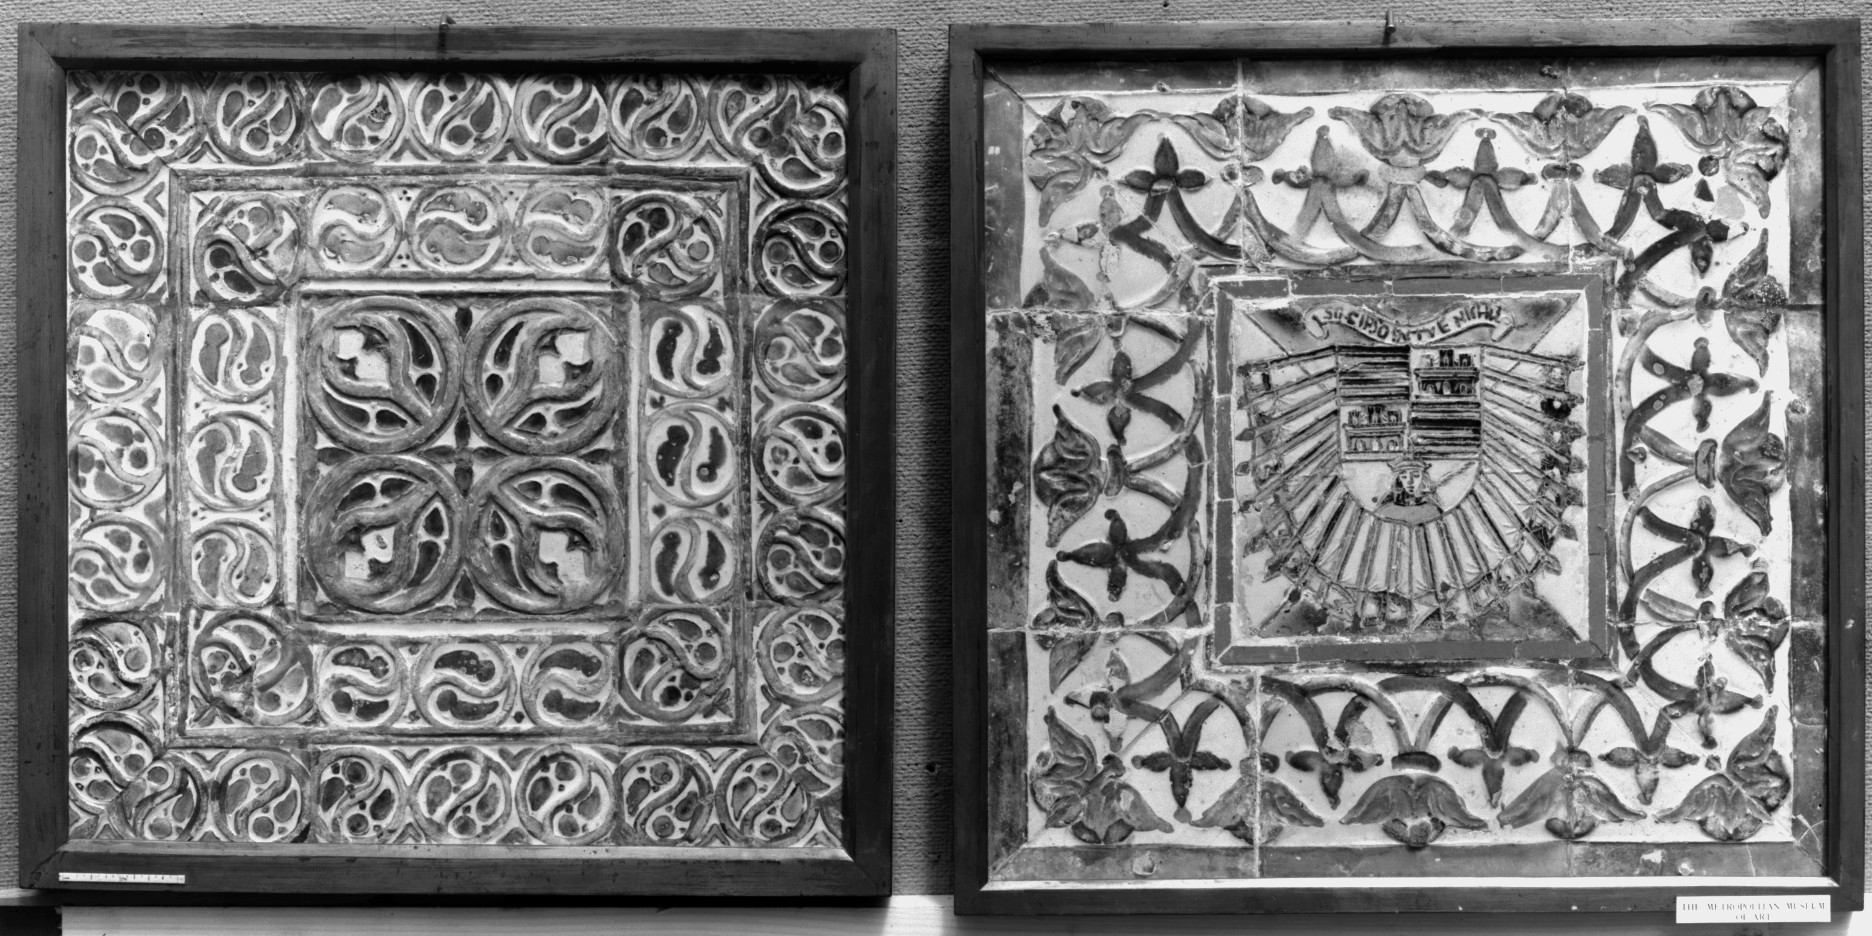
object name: tile panel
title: Wall panel tiles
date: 1501-1600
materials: earthenware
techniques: luster painting, glazing